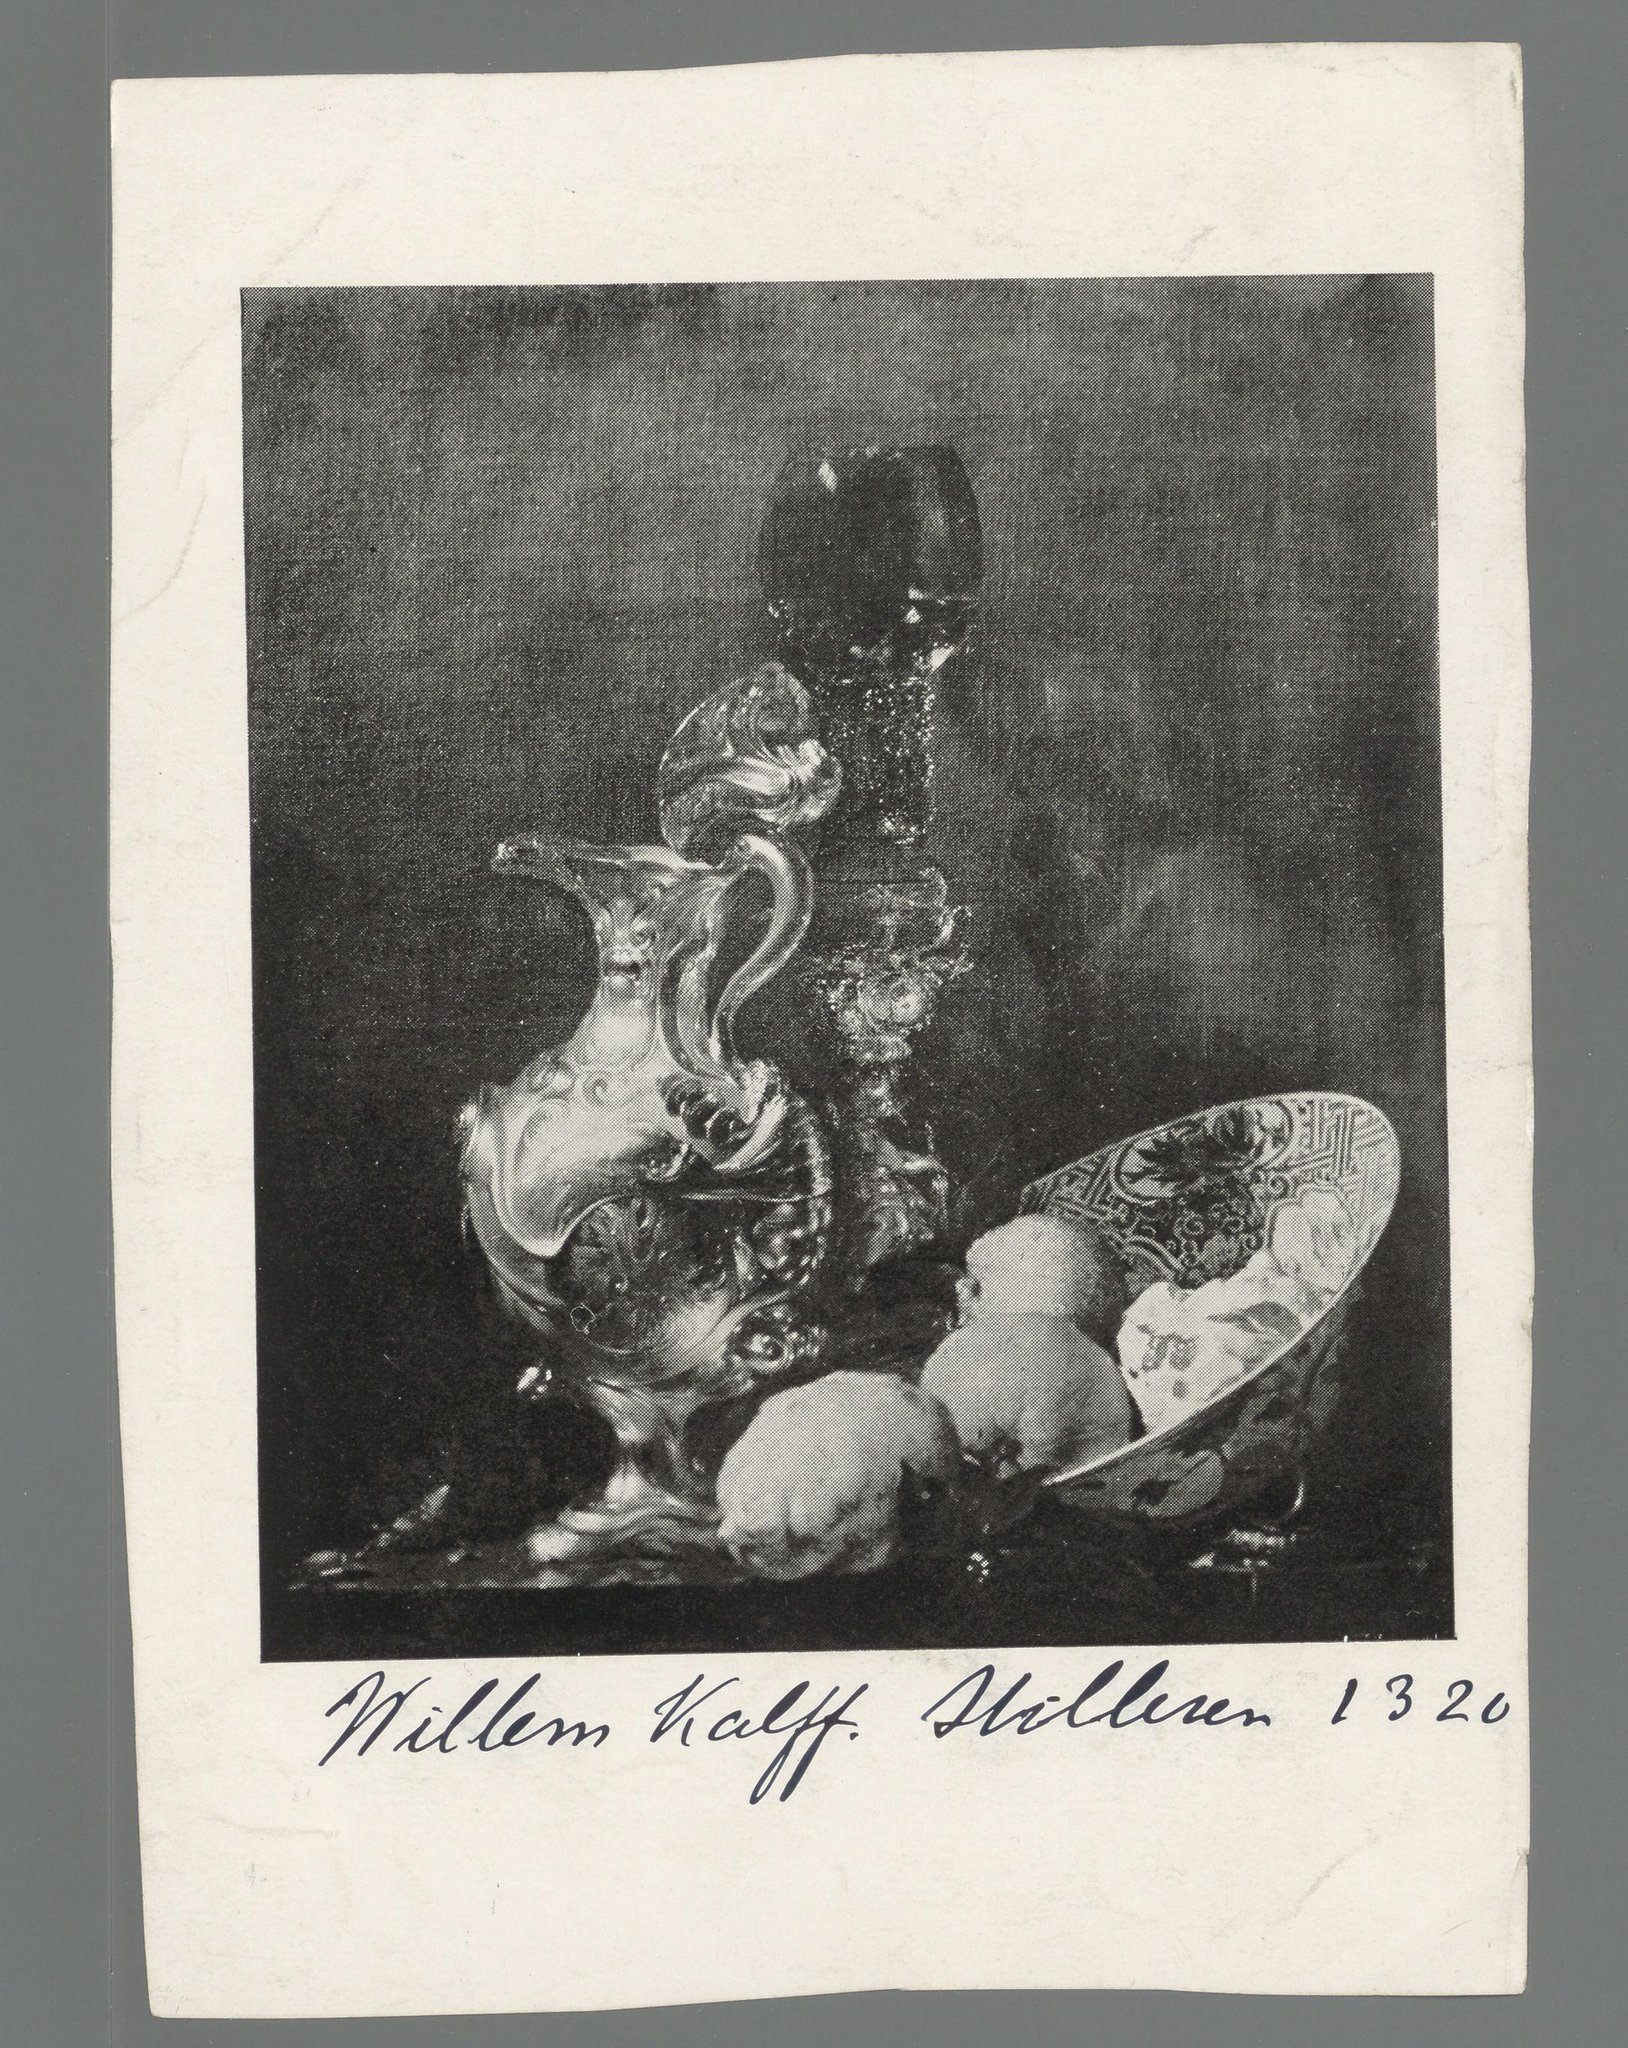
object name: reproduction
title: Galerie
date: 1920-1945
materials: cardboard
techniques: four-color autotype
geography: amsterdam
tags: jar, jug (used as drinking-vessel), still life of related objects, fruits